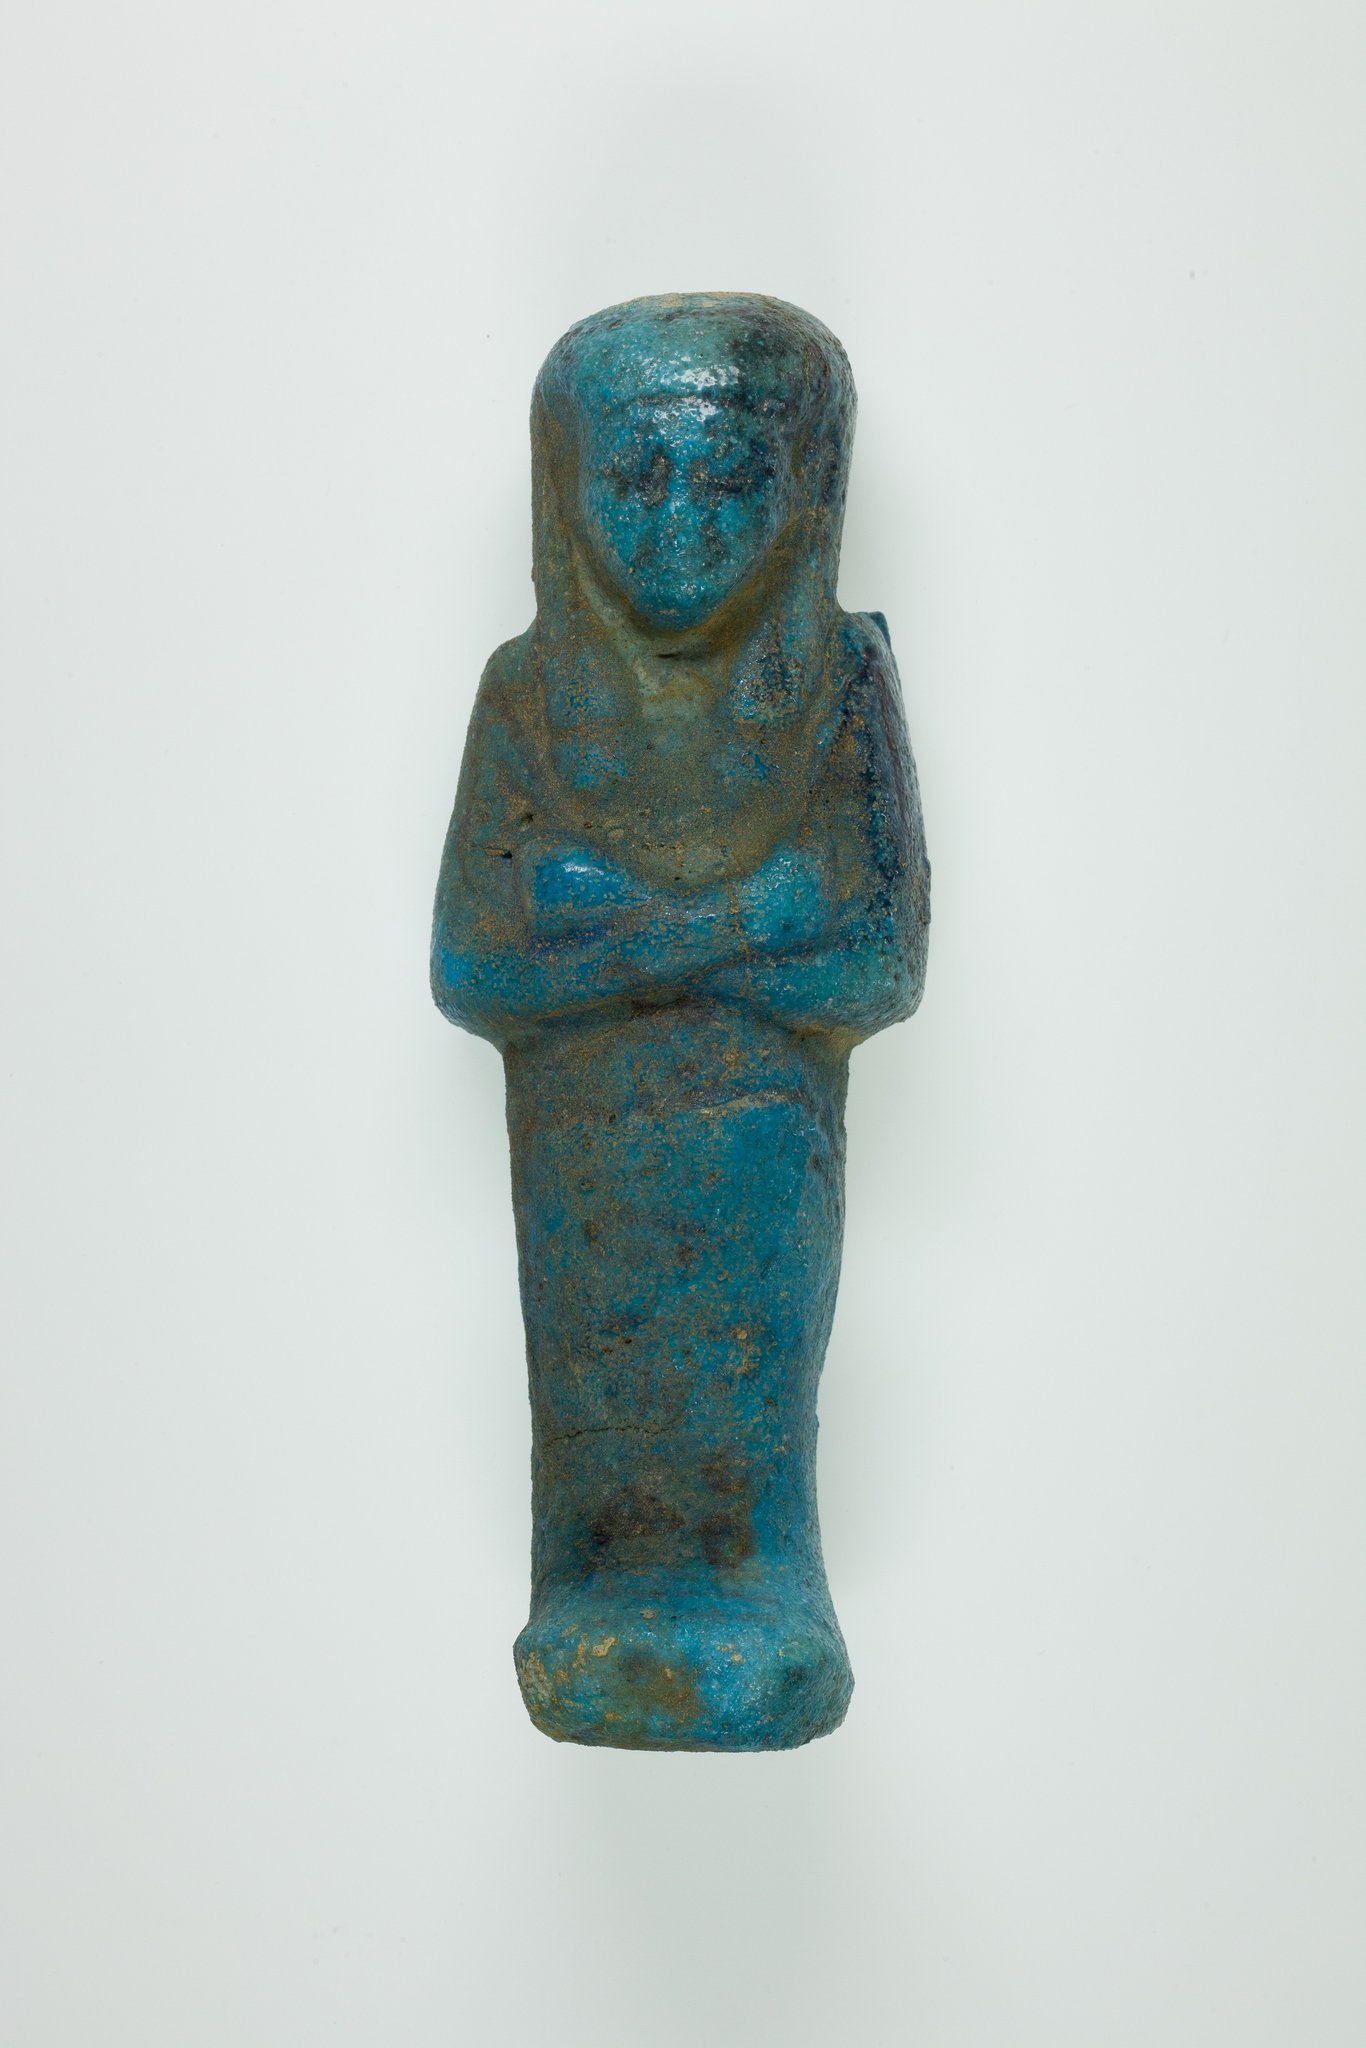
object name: worker shabti, henettawy c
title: Worker Shabti of Henettawy (C), Daughter of Isetemkheb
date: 990-970 BCE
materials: faience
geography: egypt